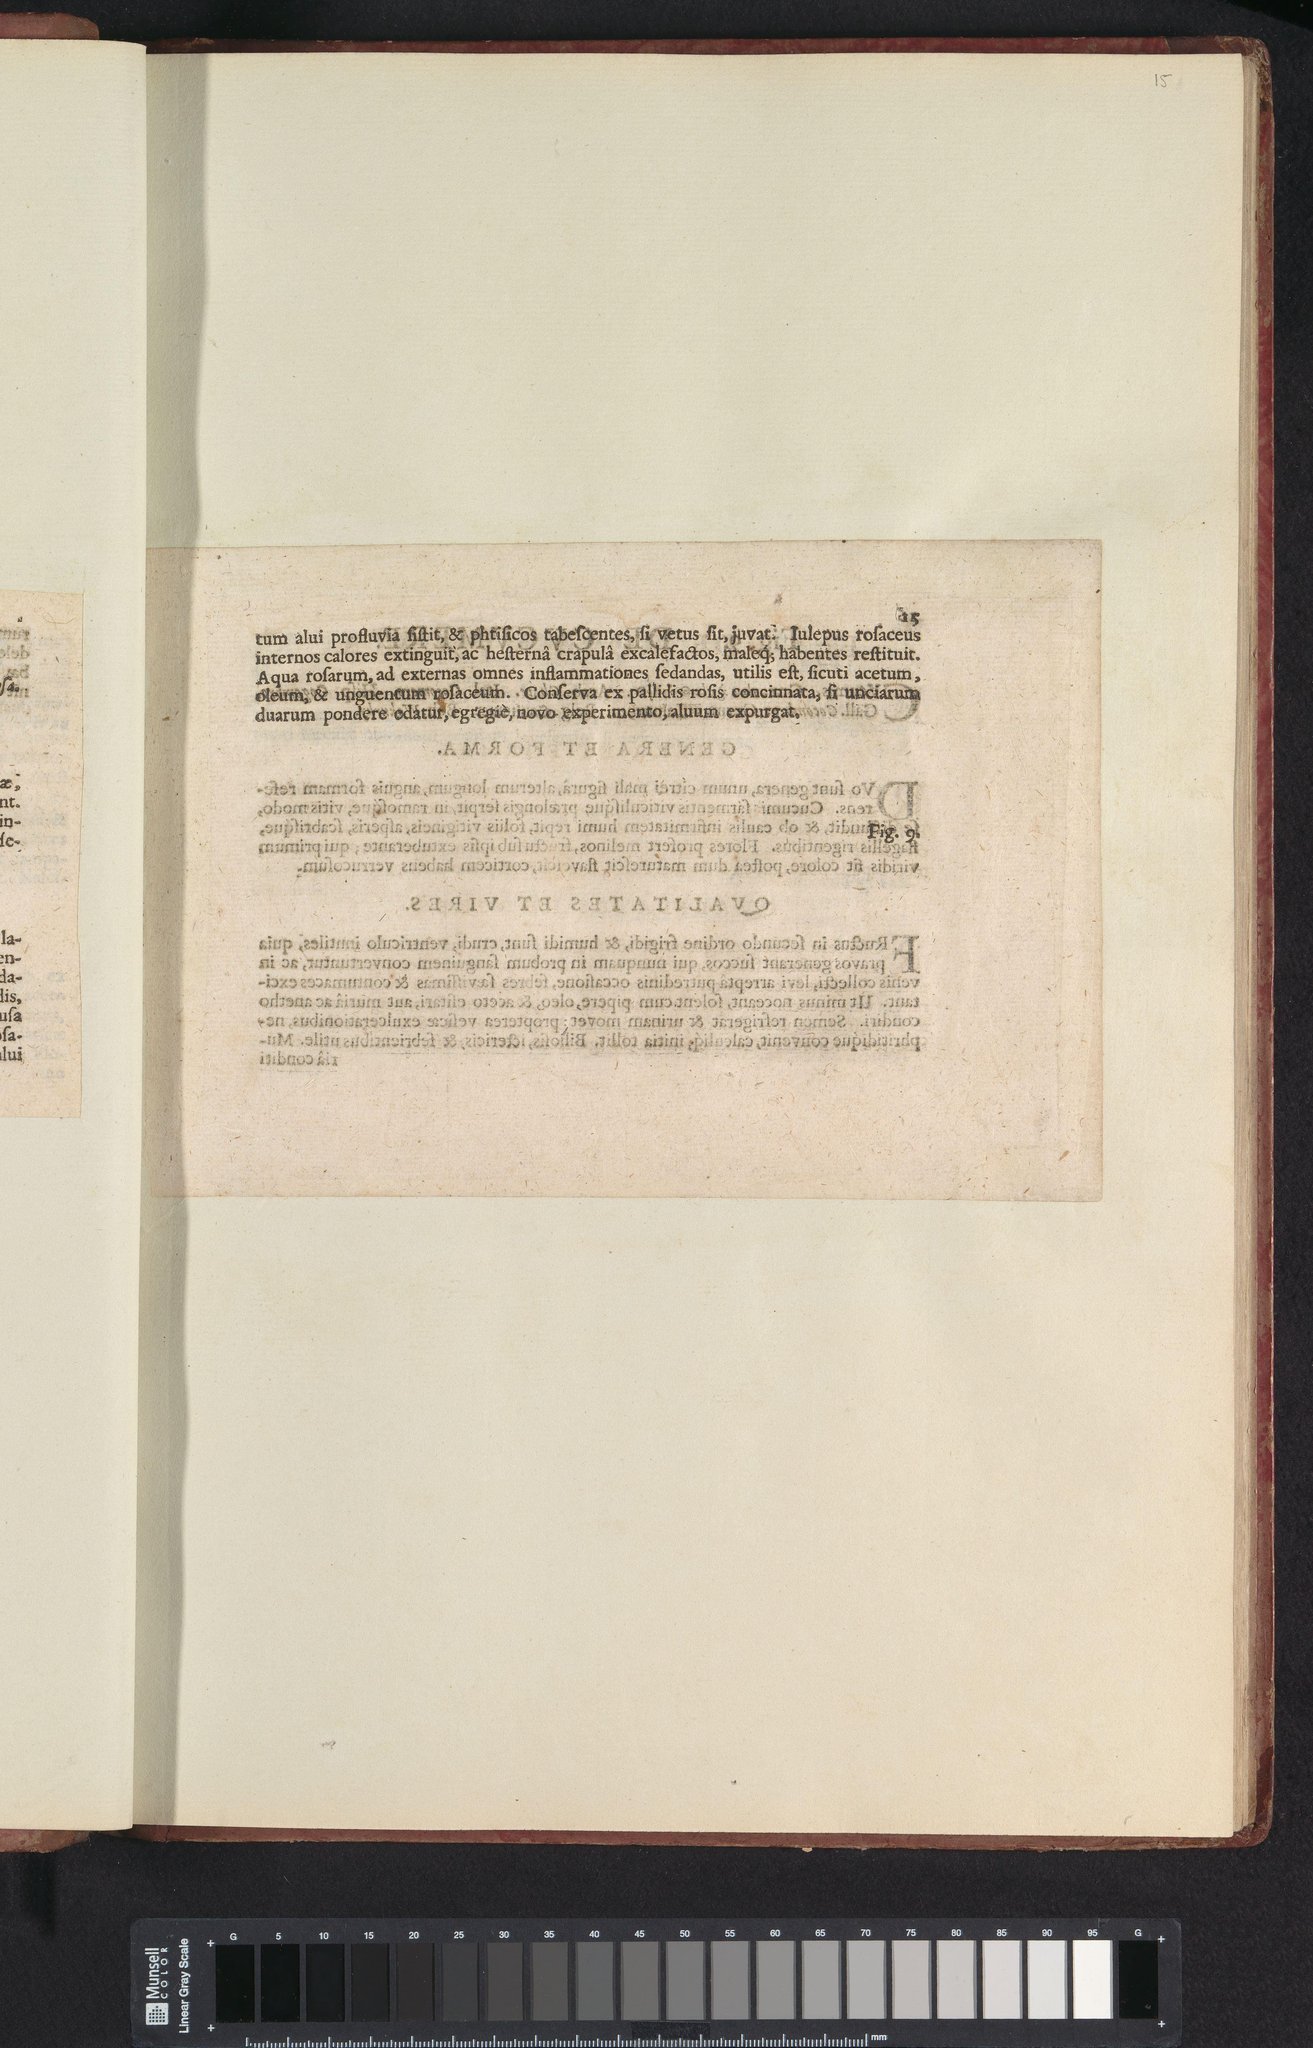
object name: text sheet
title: Fig. 8 'De Rosa Mvscata' in De Boodts herbarium van 1640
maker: anselmus boëtius de boodt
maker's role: draughtsman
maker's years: 1550-1632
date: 1640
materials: ink, paper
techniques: letterpress printing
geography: bruges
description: Beschrijving bij Fig. 8 op p. 15 in: Anselmi Boëtii de Boot I.C. Brugensis & Rodolphi II. Imp. Roman. medici a cubiculis Florum, Herbarum, ac fructuum selectiorum icones, & vires pleraeque hactenus ignotæ. Onderdeel van het album met bladen en platen uit De Boodts herbarium van 1640. Het twaalfde van twaalf albums met aquarellen van dieren, vogels en planten bekend rond 1600, gemaakt in opdracht van keizer Rudolf II.